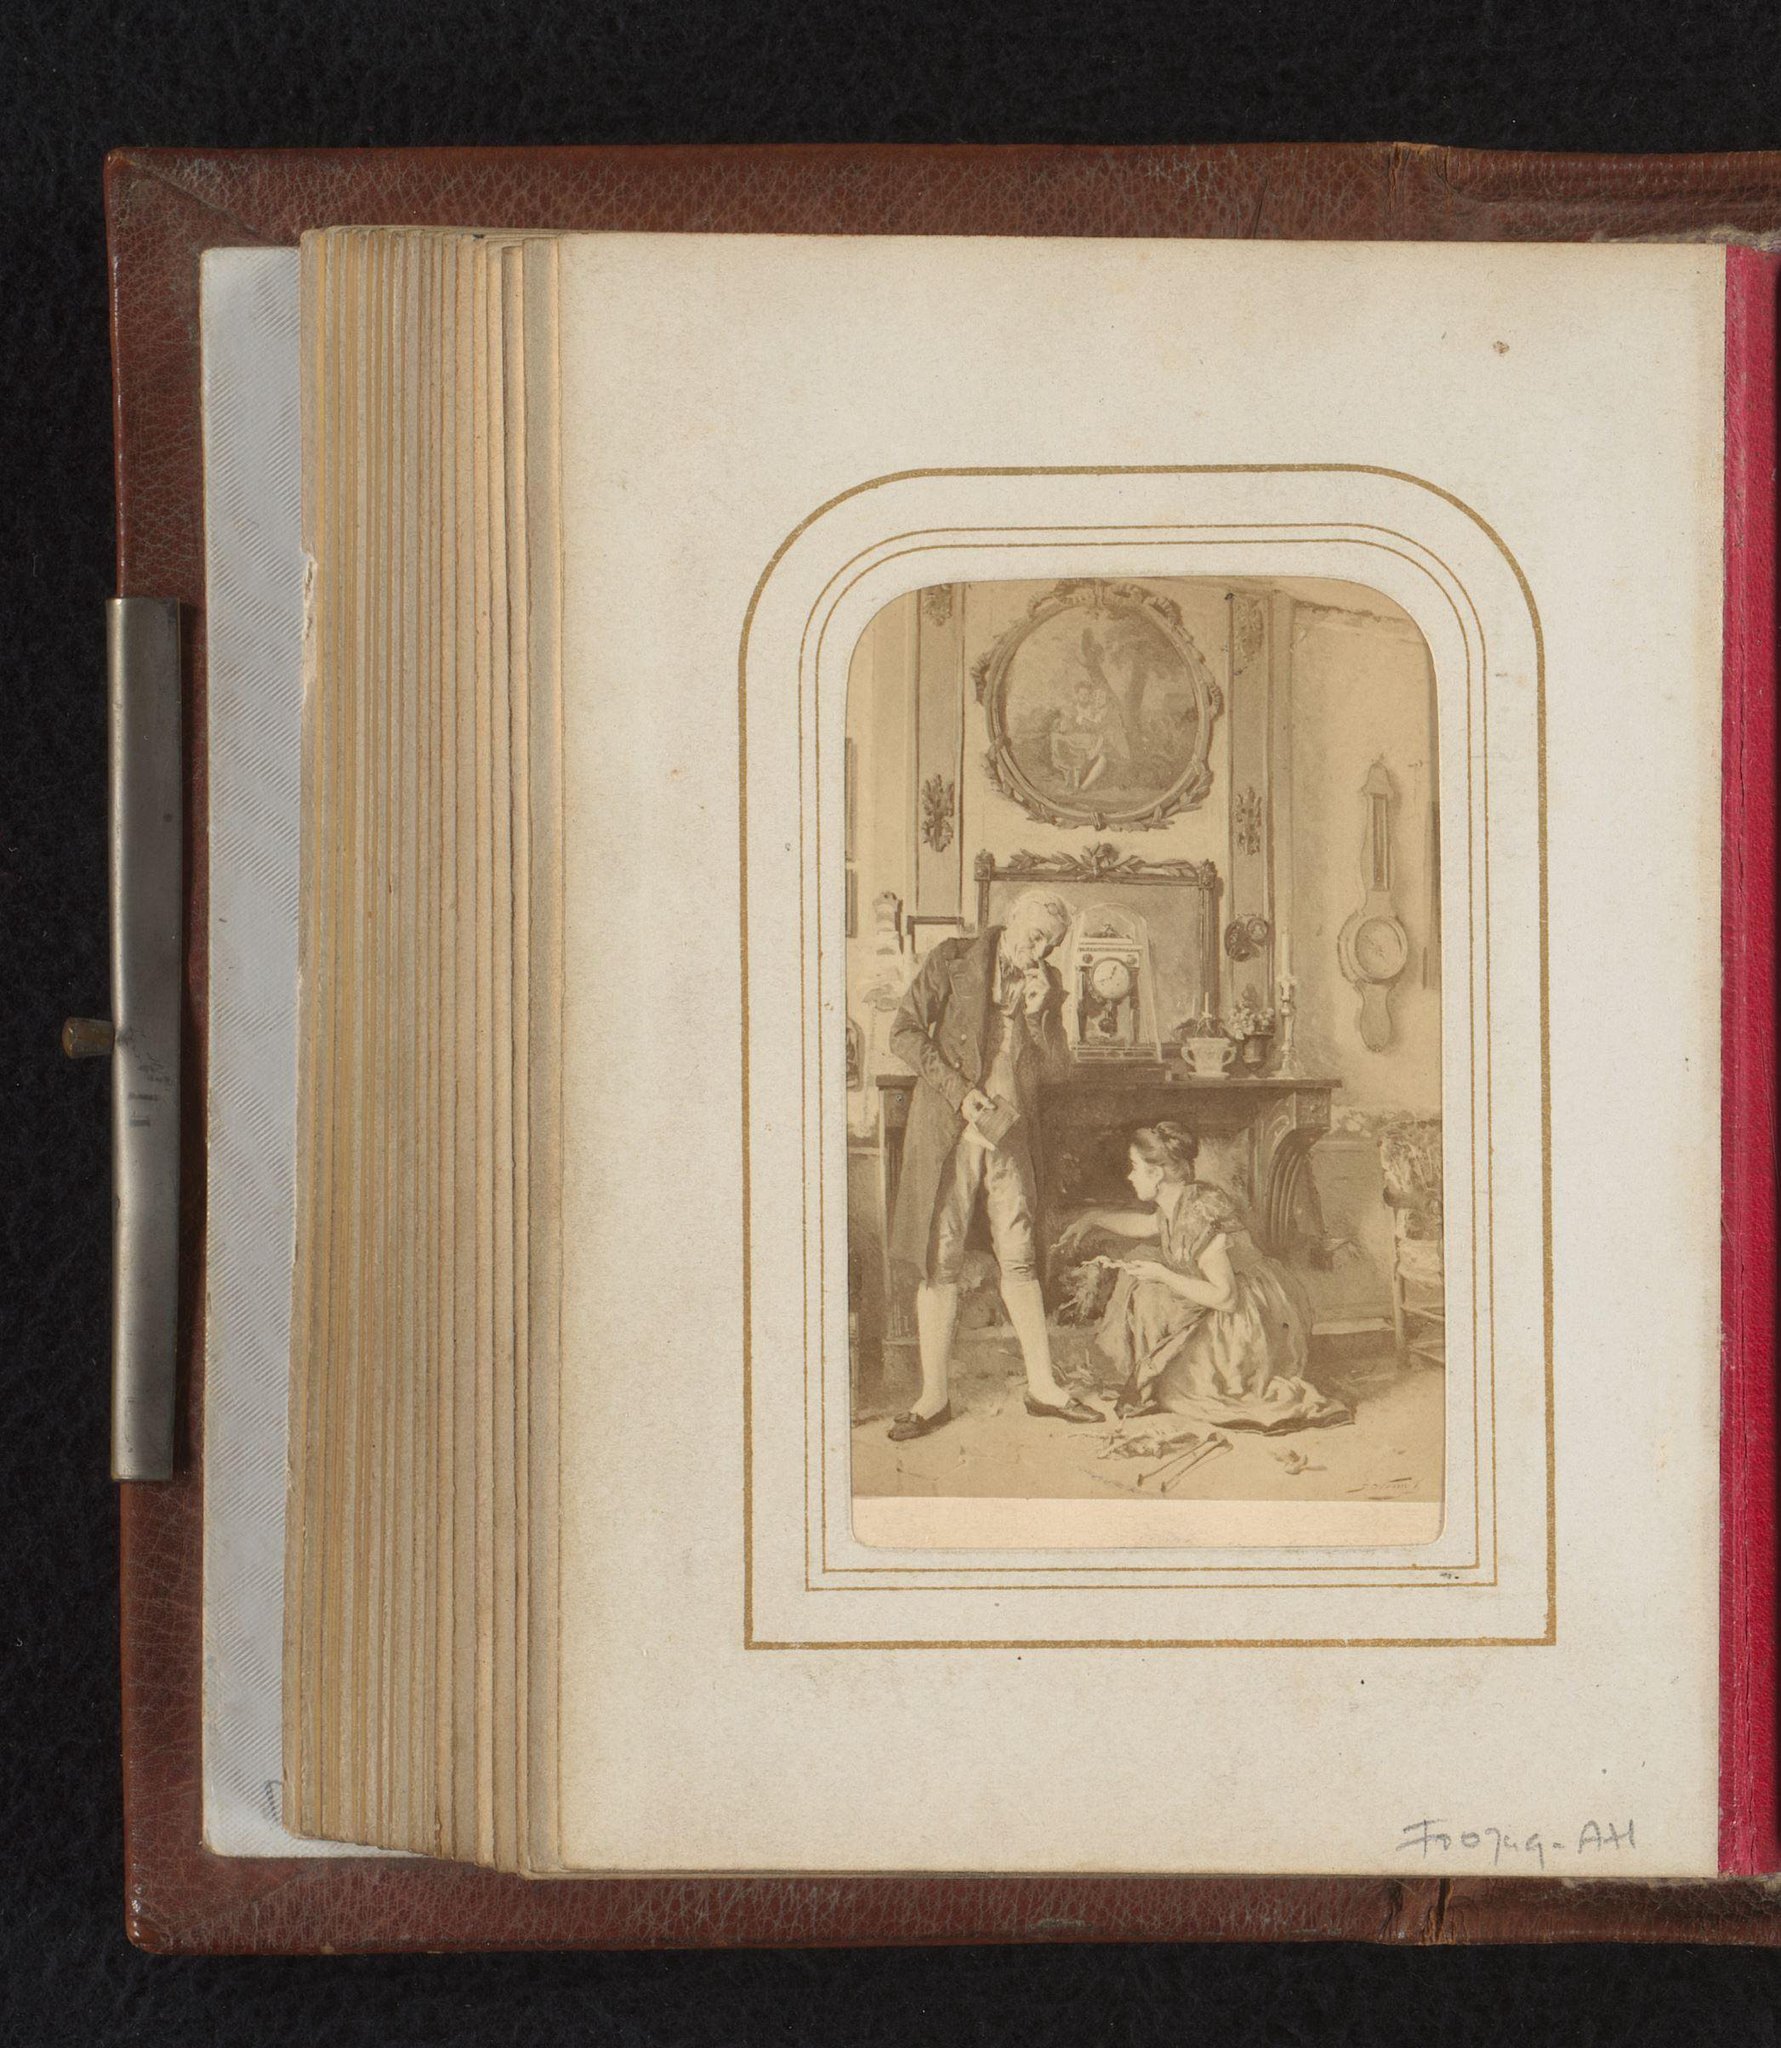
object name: carte de visite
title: Fotoreproductie van Un feu qui couve, geschilderd door Jules Worms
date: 1865-1900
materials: cardboard, photographic support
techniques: albumen print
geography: paris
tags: open hearth, fire-place, interior of the house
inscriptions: inscription: ‘Goupil & Cie/ Éditeurs/ 9, rue Chaptal, 9/ Paris’, inscription: ‘No 1242/ Un feu qui couve/ A smouldering fire, Ein erst ektes Feuer/ Peint par J. Worms’